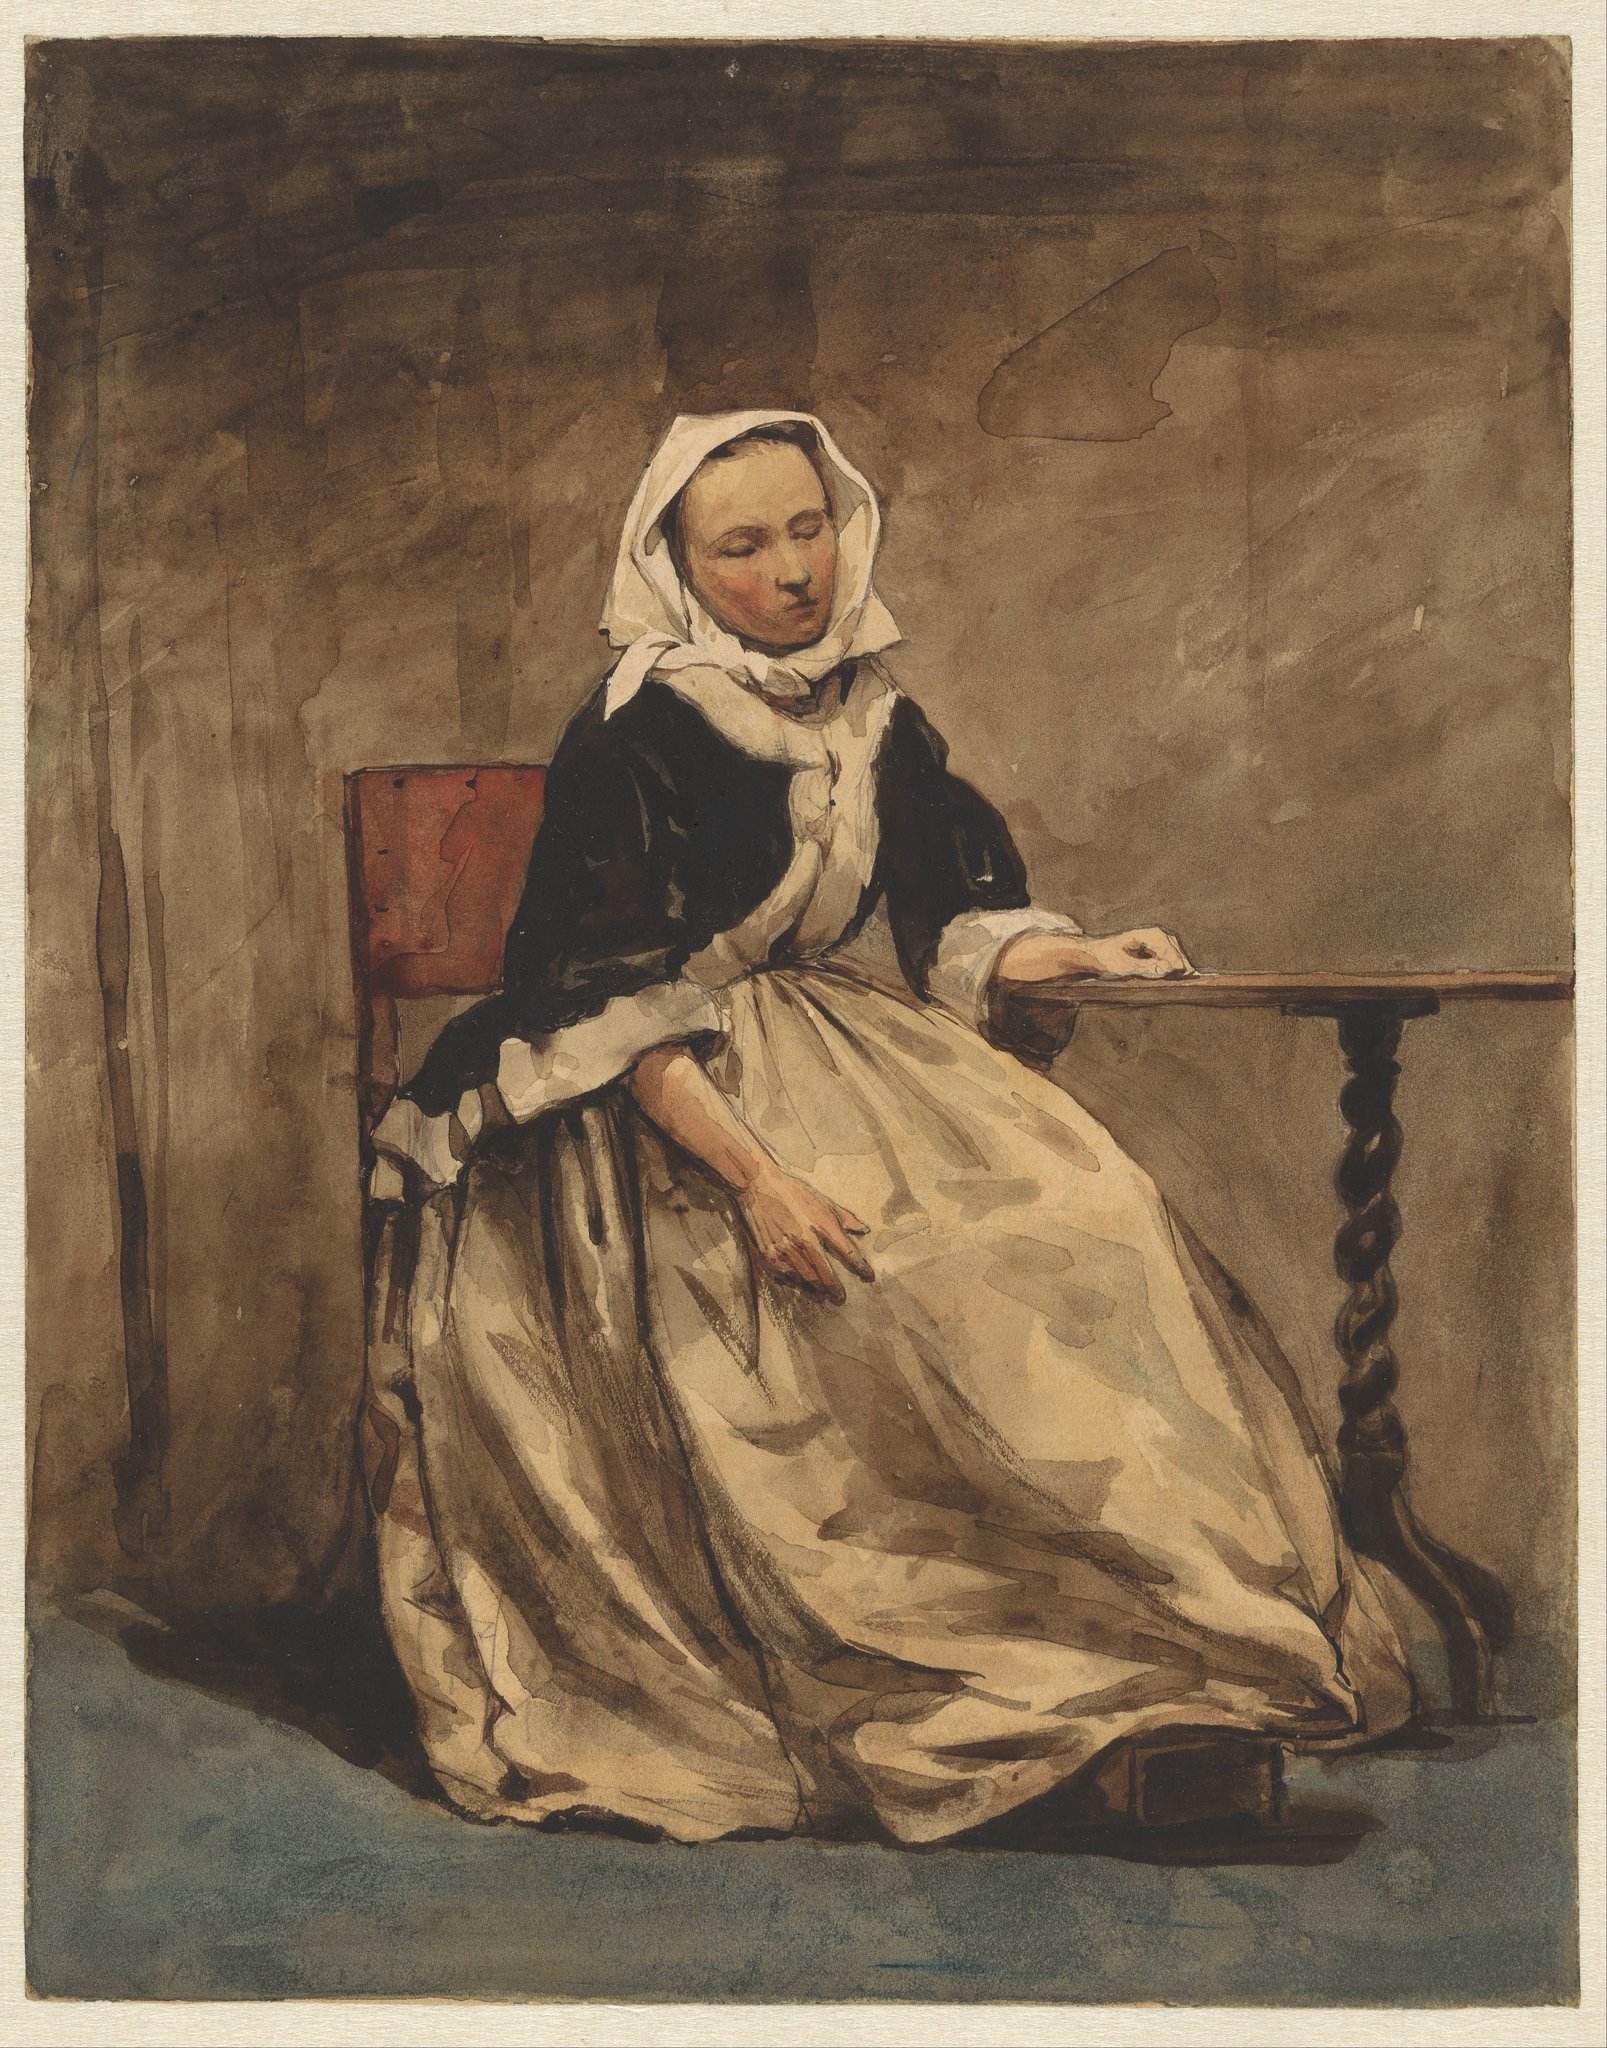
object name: watercolor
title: Zittende vrouw naast een kleine tafel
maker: jan weissenbruch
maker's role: painter, print maker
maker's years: 1822-1880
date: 1832-1880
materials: paper, pencil, watercolor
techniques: brush